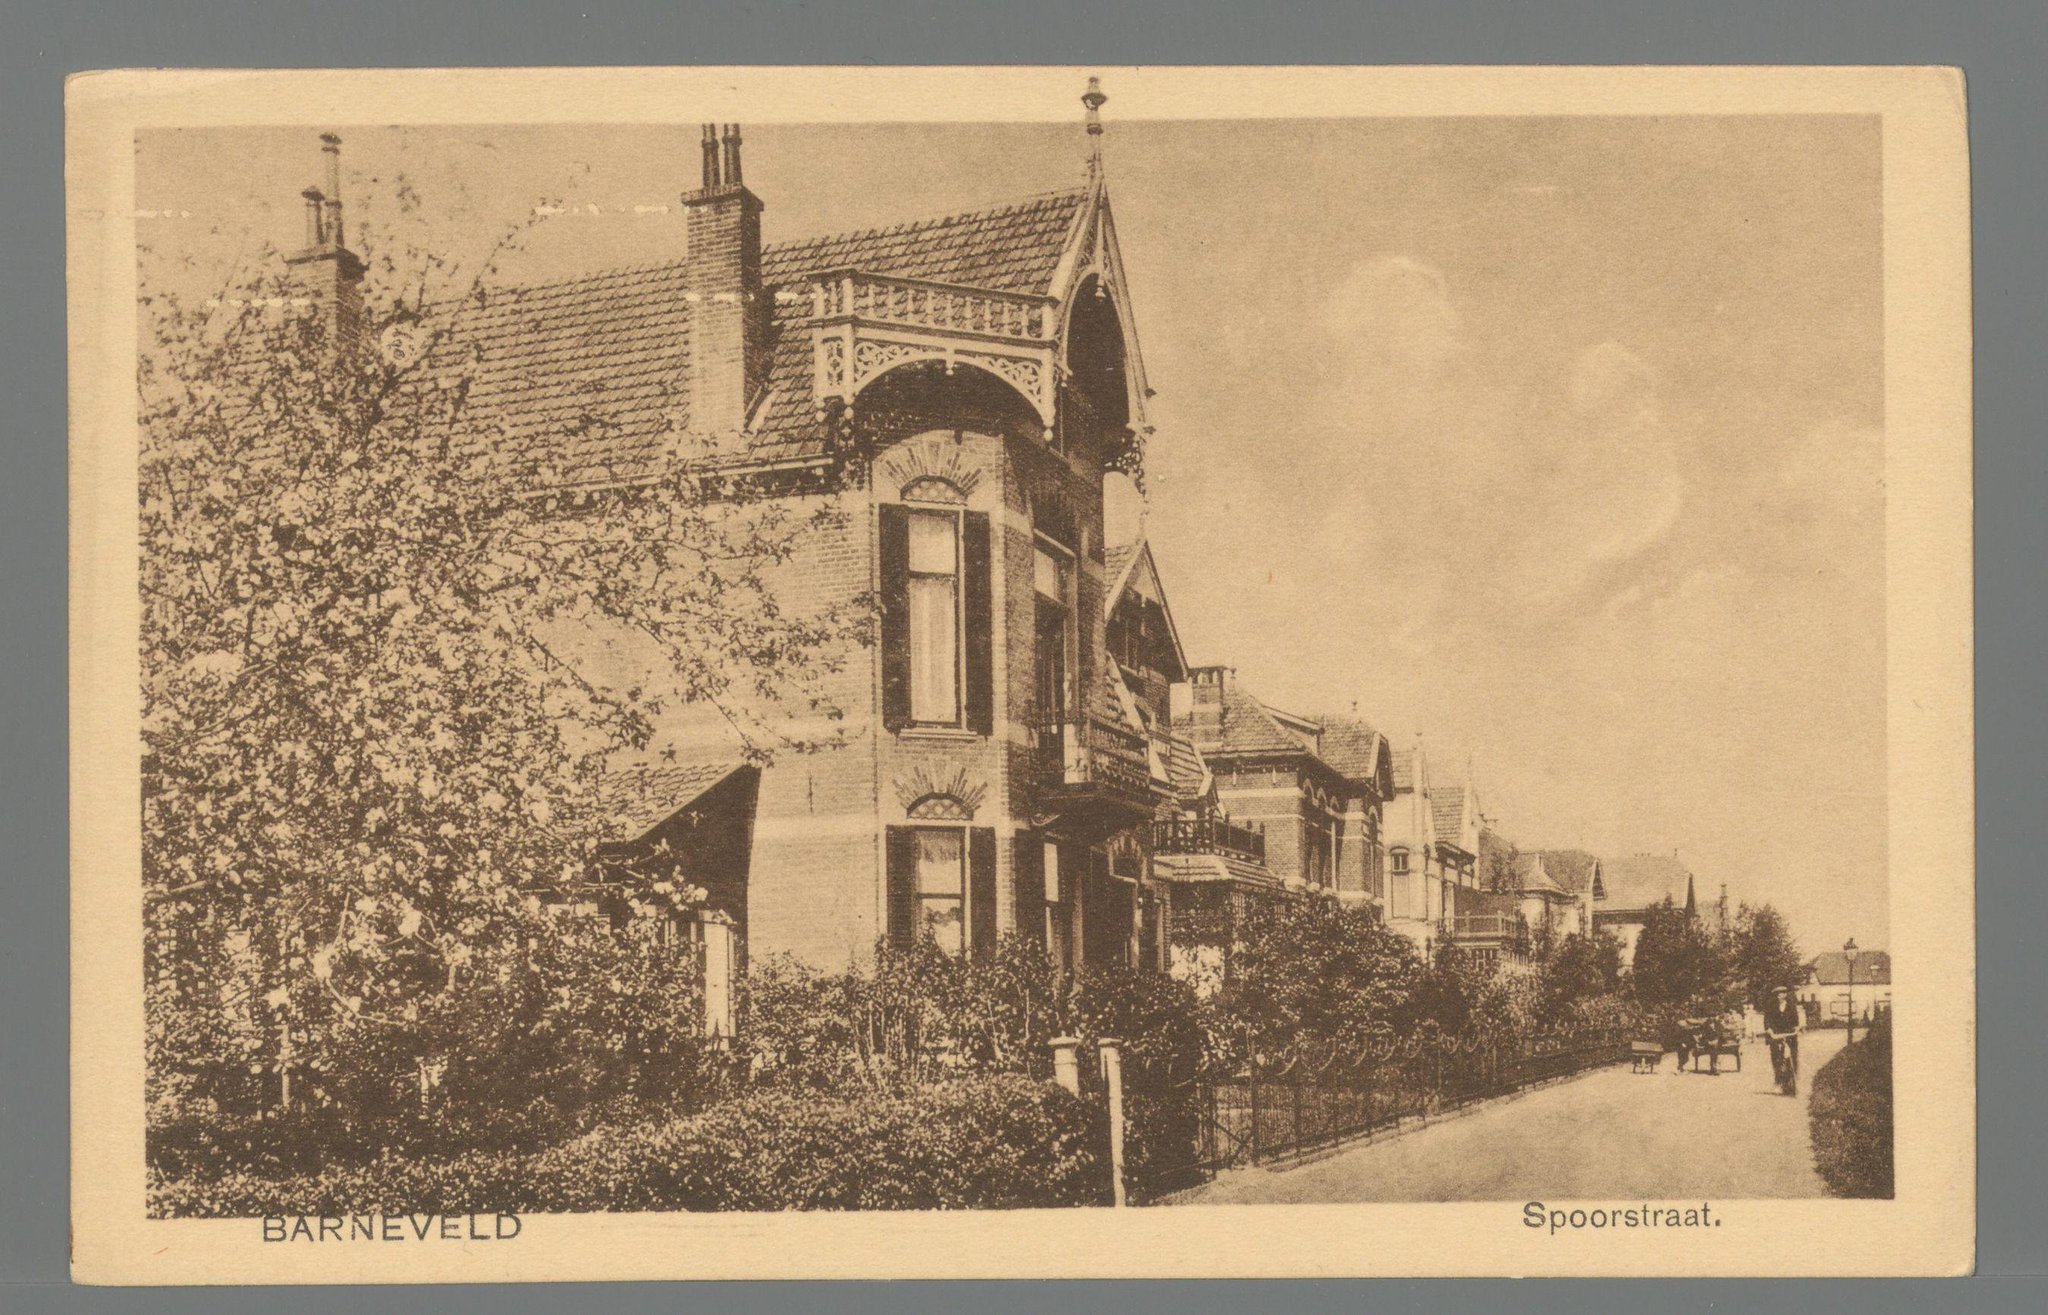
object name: ansichtkaart, prentbriefkaart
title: Barneveld. Spoorstraat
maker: Anonymous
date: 1913-1930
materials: cardboard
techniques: photograph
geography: barneveld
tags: street